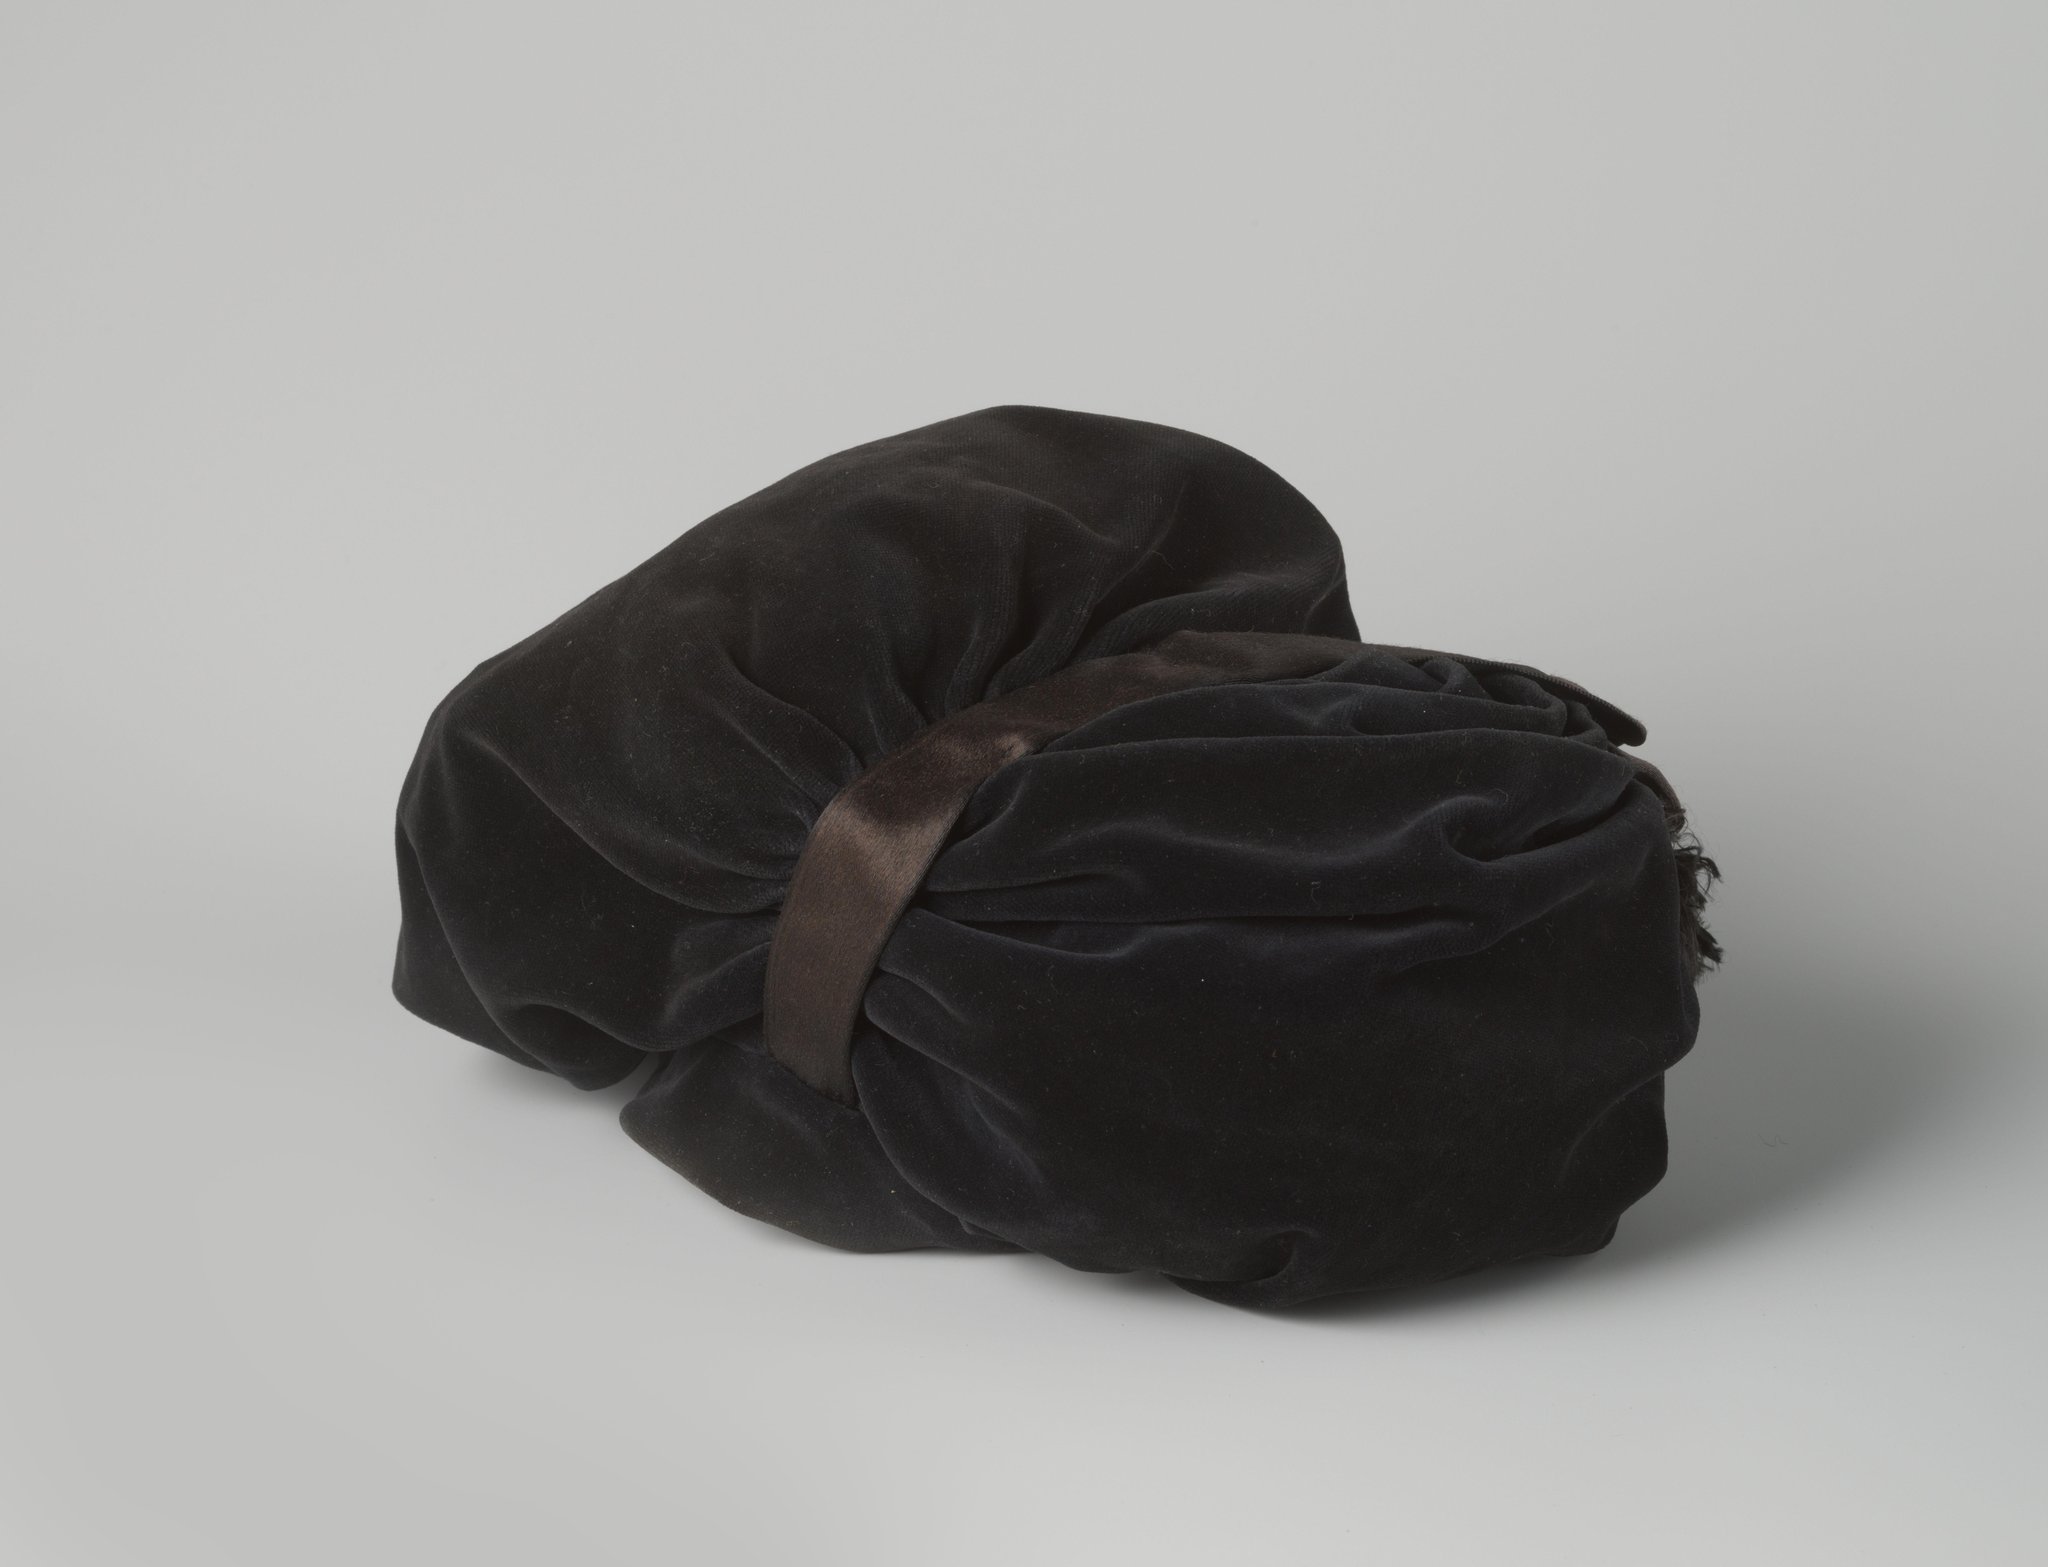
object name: beret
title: Baret van zwart zijdefluweel versierd met een zwart satijnen band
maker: dresselhuys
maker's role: modiste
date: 1950-1960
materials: textile, silk, velvet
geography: amsterdam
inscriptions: address: ‘Dresselhuys/Willemsparkweg 61/Amsterdam/tel. 92509.’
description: Baret van zwart zijdefluweel versierd met een zwart satijnen band. Asymmetrisch aangerimpelde bol, fluwelen rand, die aan de binnenkant is afgewerkt met breed zwart ripslint. Ongevoerd. Over de rimpeling loopt een brede zwart satijnen band, die achterop in franjes eindigt. Adres: Dresselhuys/Willemsparkweg 61/Amsterdam/tel. 92509.